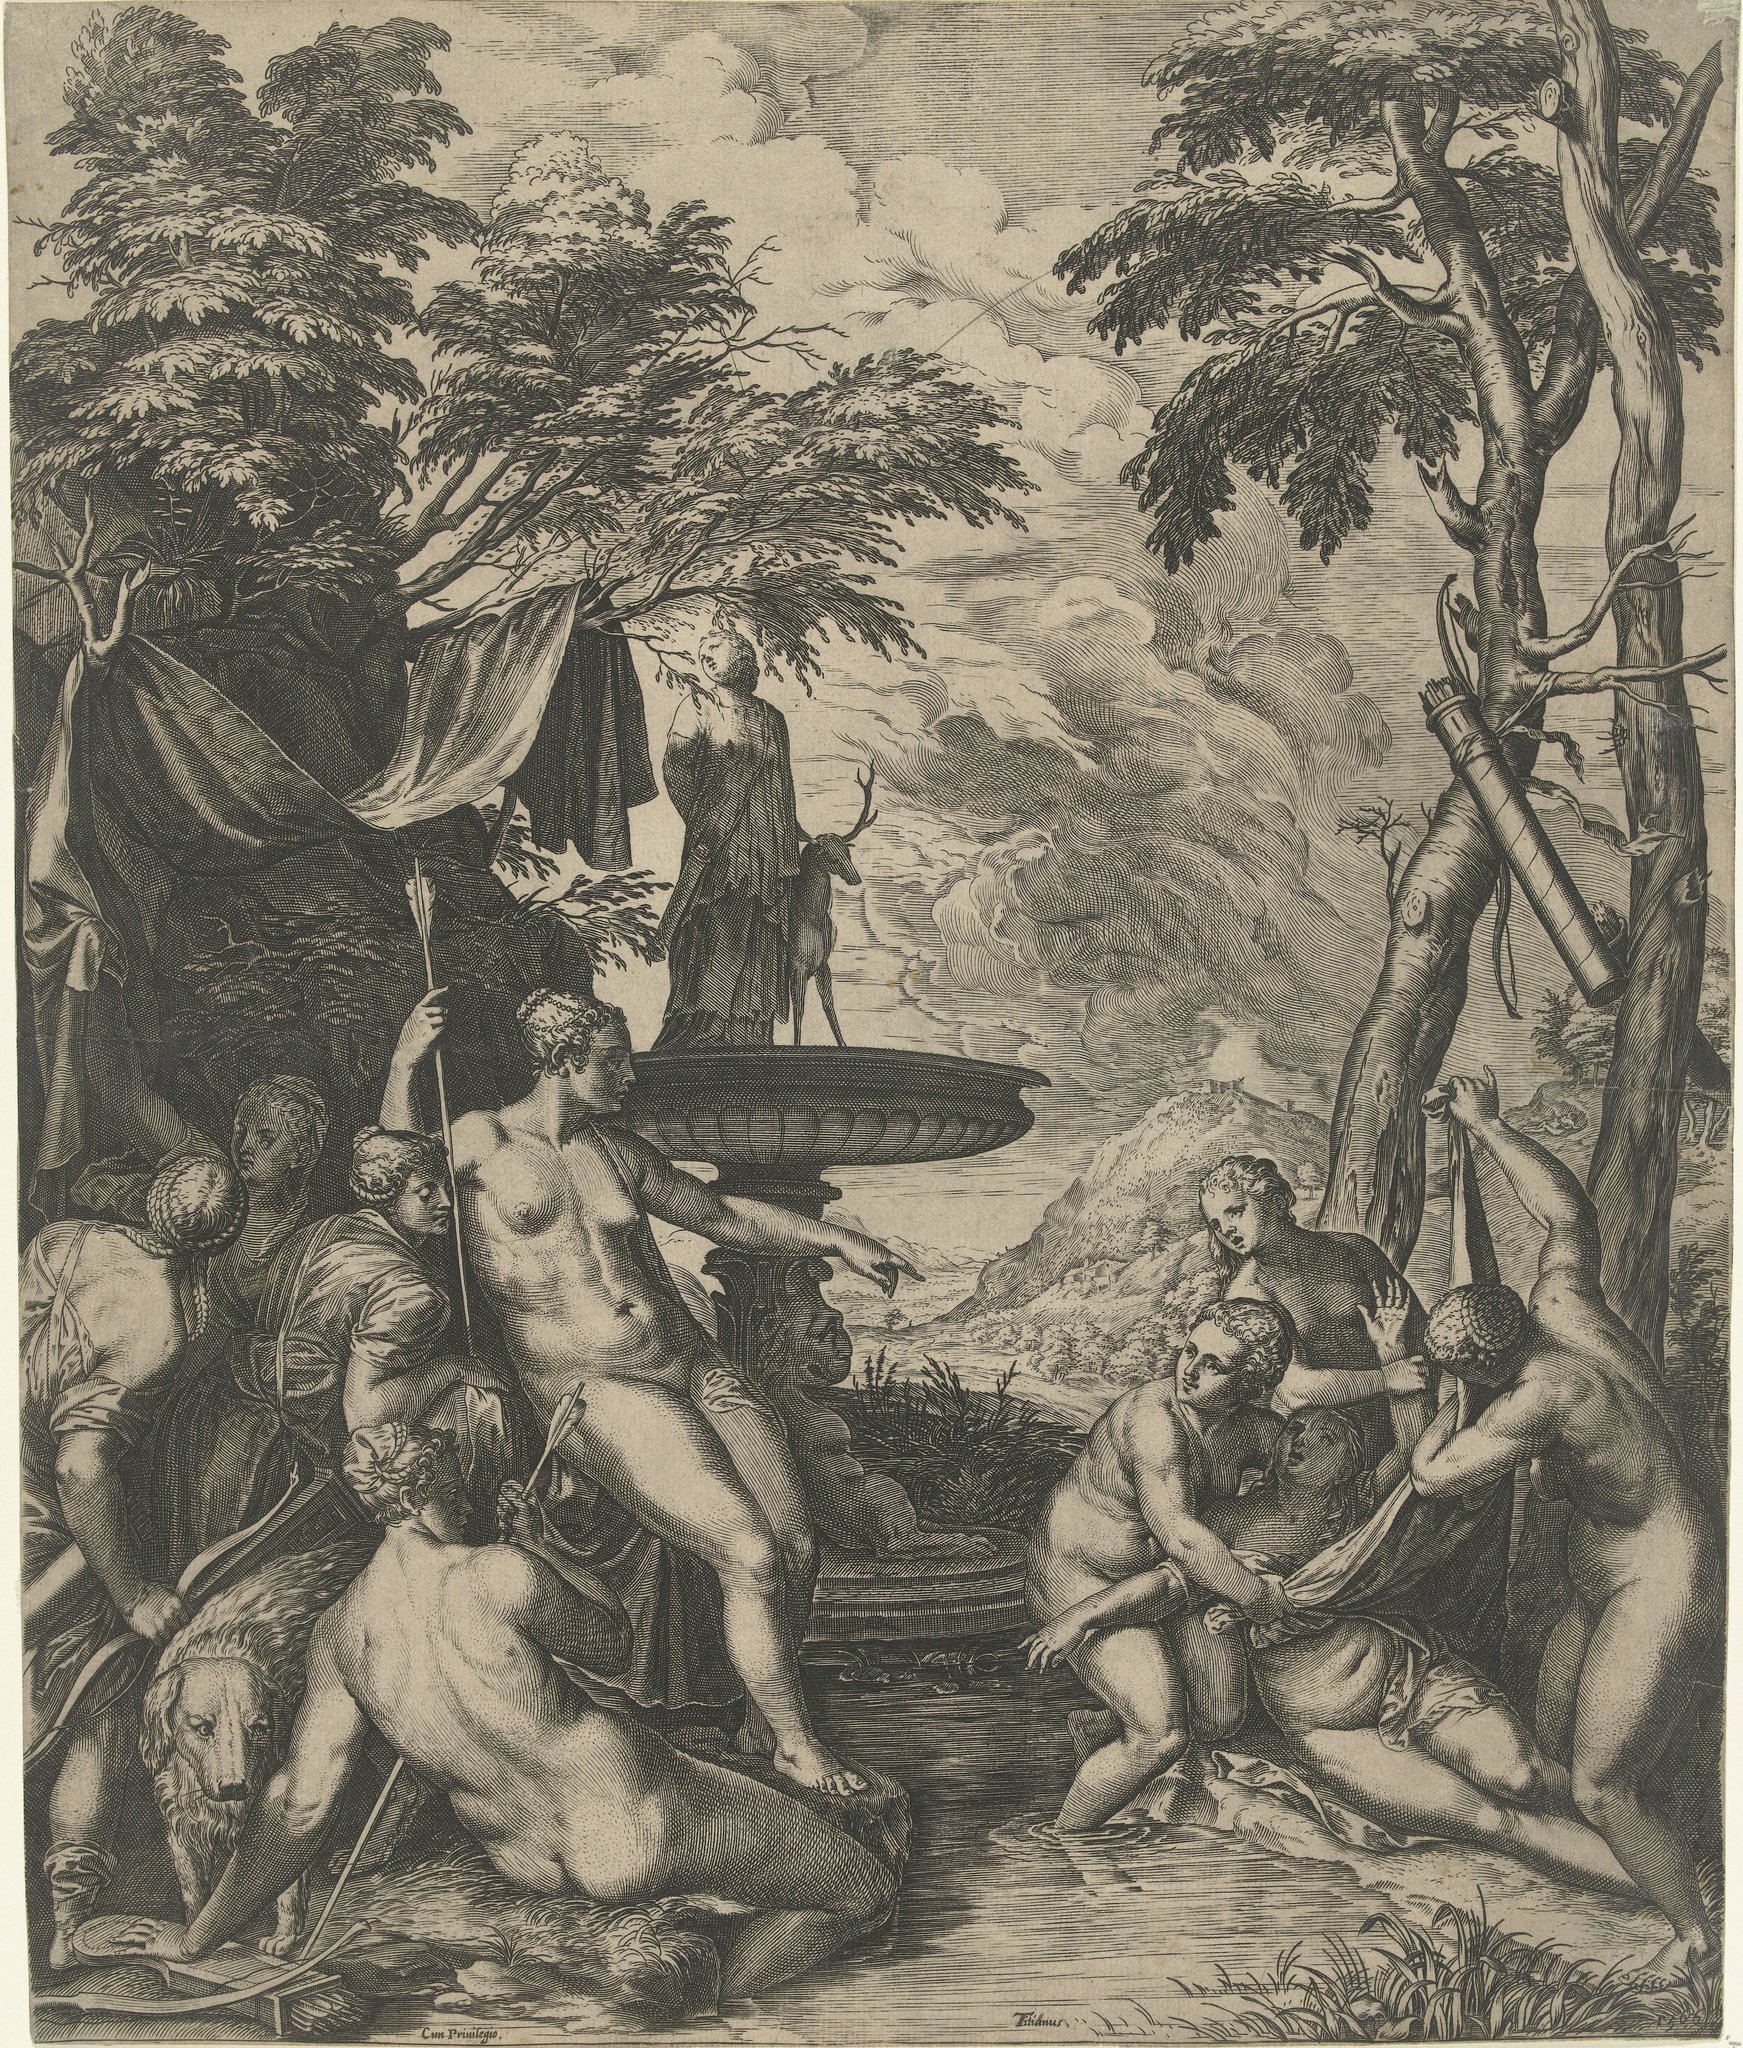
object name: print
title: Diana ontdekt de zwangerschap van Callisto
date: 1566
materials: paper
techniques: engraving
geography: rome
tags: diana with her nymphs discovers the pregnancy of callisto, pregnancy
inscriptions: collector's mark: Lugt 2228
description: Diana neemt samen met haar nimfen een bad. Ze ontdekt verontrust dat haar nimf Callisto zwanger is. Op de achtergrond een fontein met een beeld van Diana met een hert.